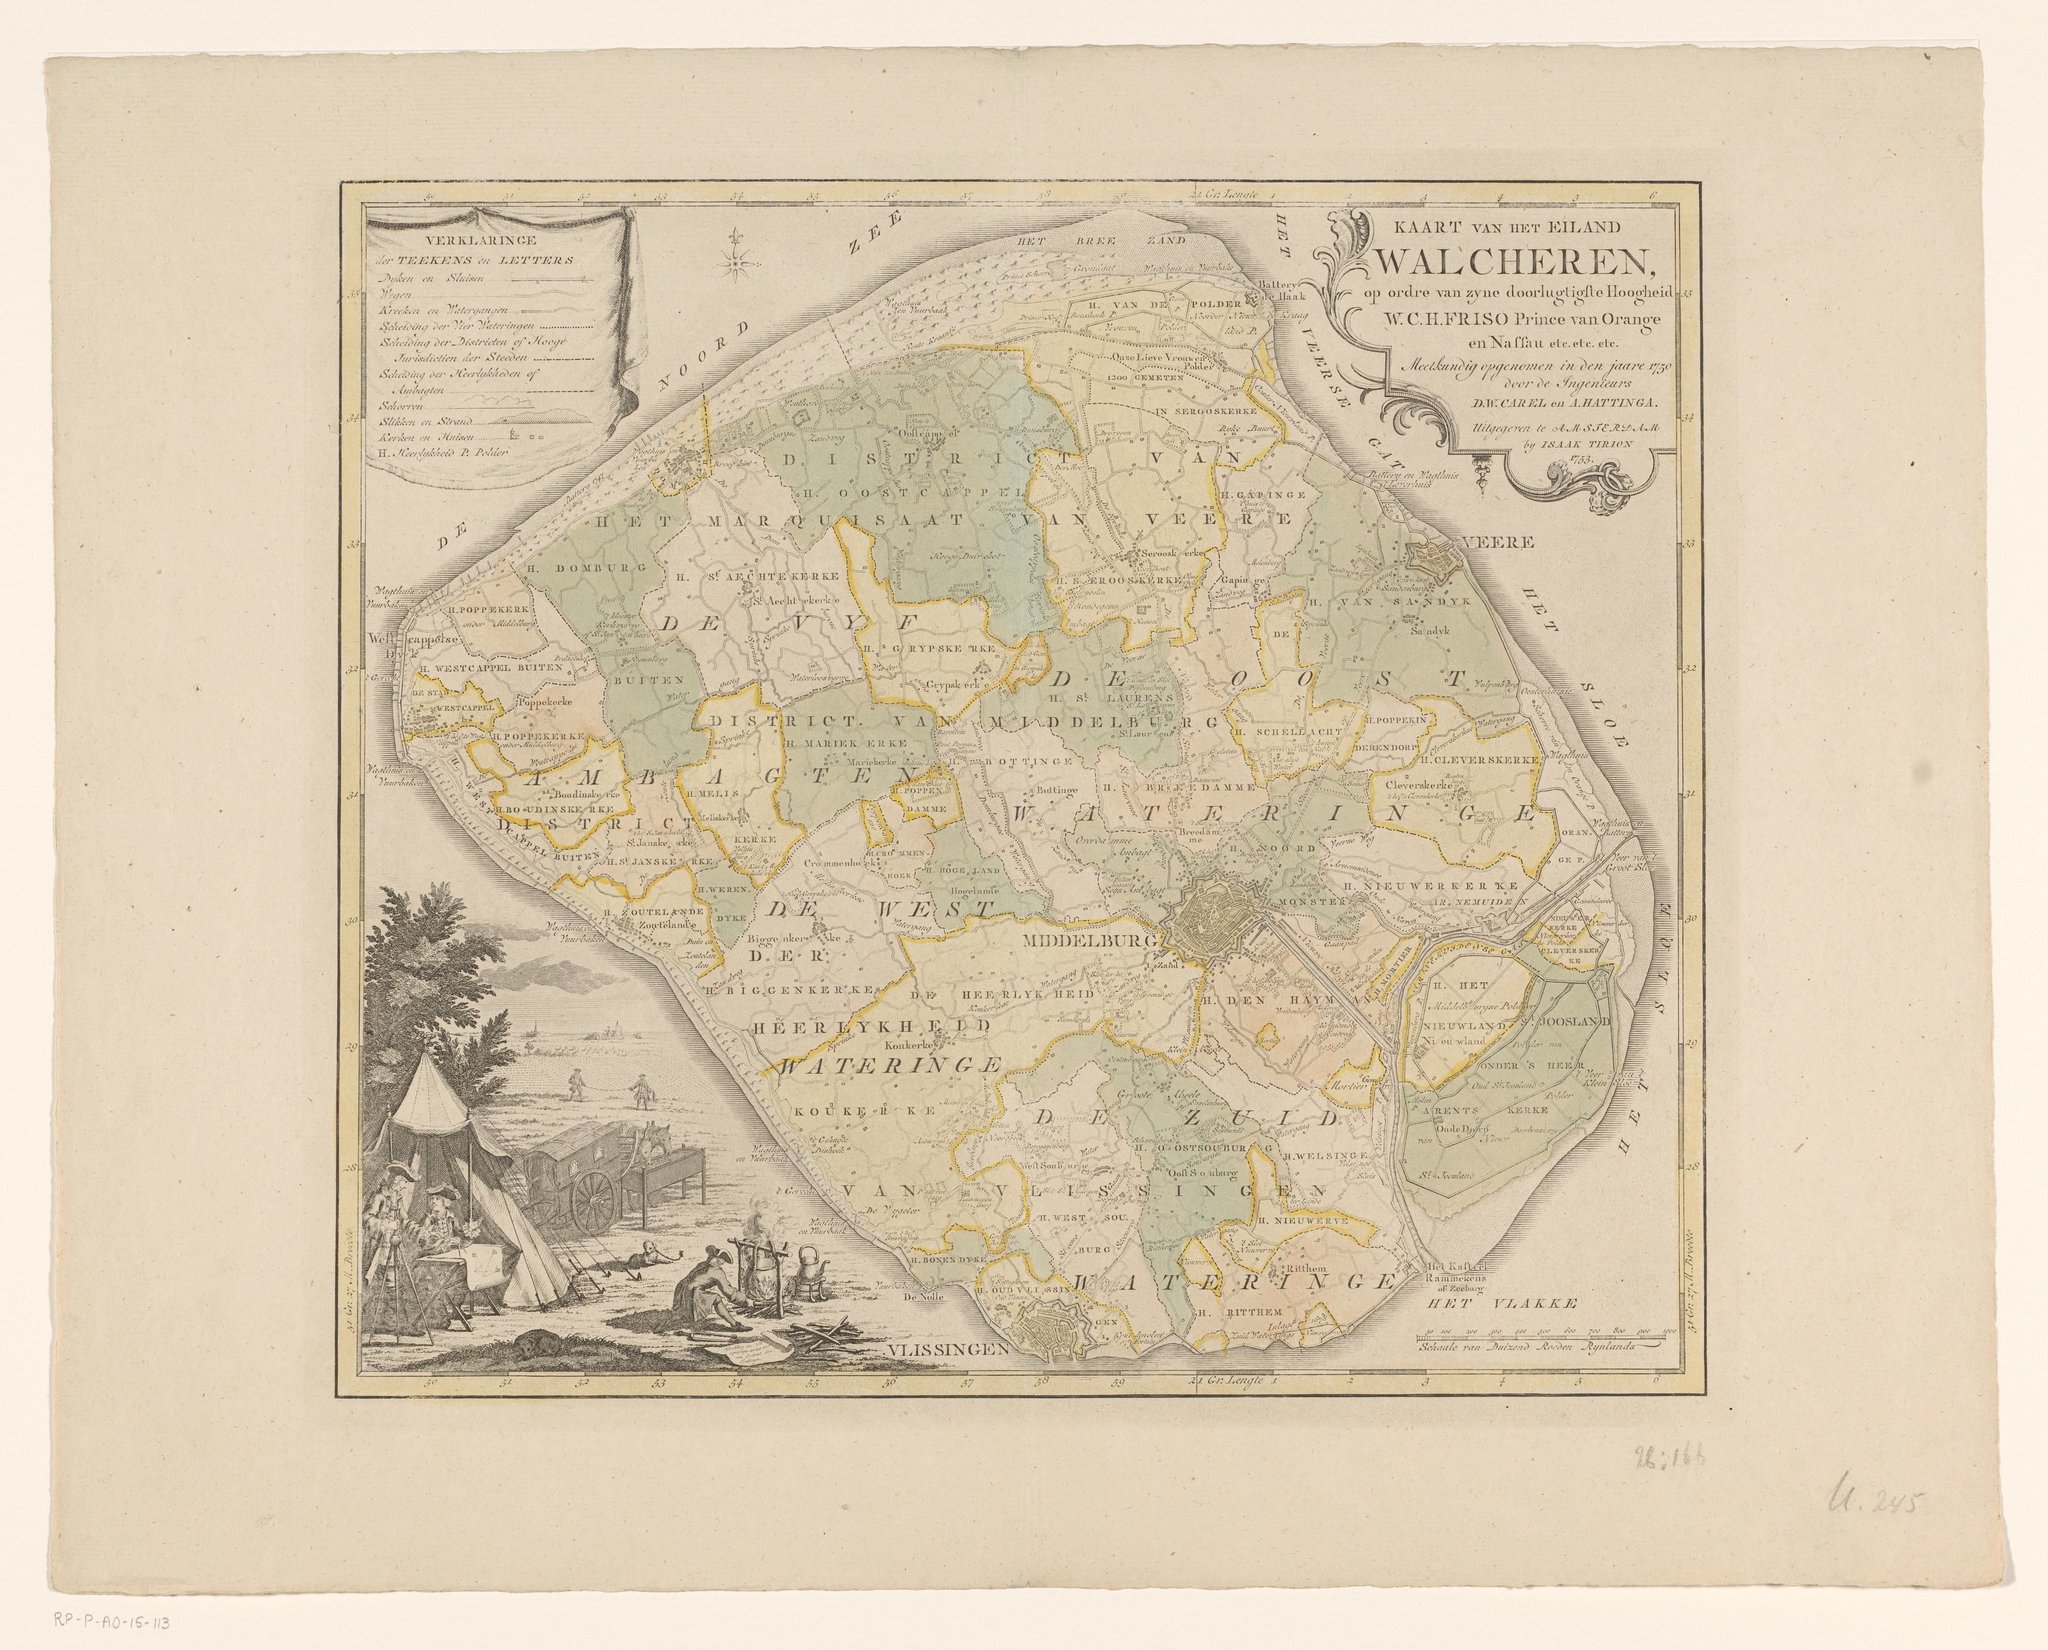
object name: map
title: Kaart van Walcheren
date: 1753-1760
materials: paper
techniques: engraving, etching, hand coloring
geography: amsterdam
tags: maps of separate countries or regions, geodesy, surveying, instruments used in geodesy, surveying instruments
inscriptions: collector's mark: Lugt 19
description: Linksboven een cartouche met de legenda. Linksonder een voorstelling van de landmeters Hattinga te werk tijdens het meten van Zeeland ('Afbeelding der veld equipagie tot het meet van Zeeland, door Hattinga'). Rechtsboven de titelcartouche. Rechtsonder een schaalstok: Schaale van duizend roeden Rynlands. Gradenverdeling langs de randen.